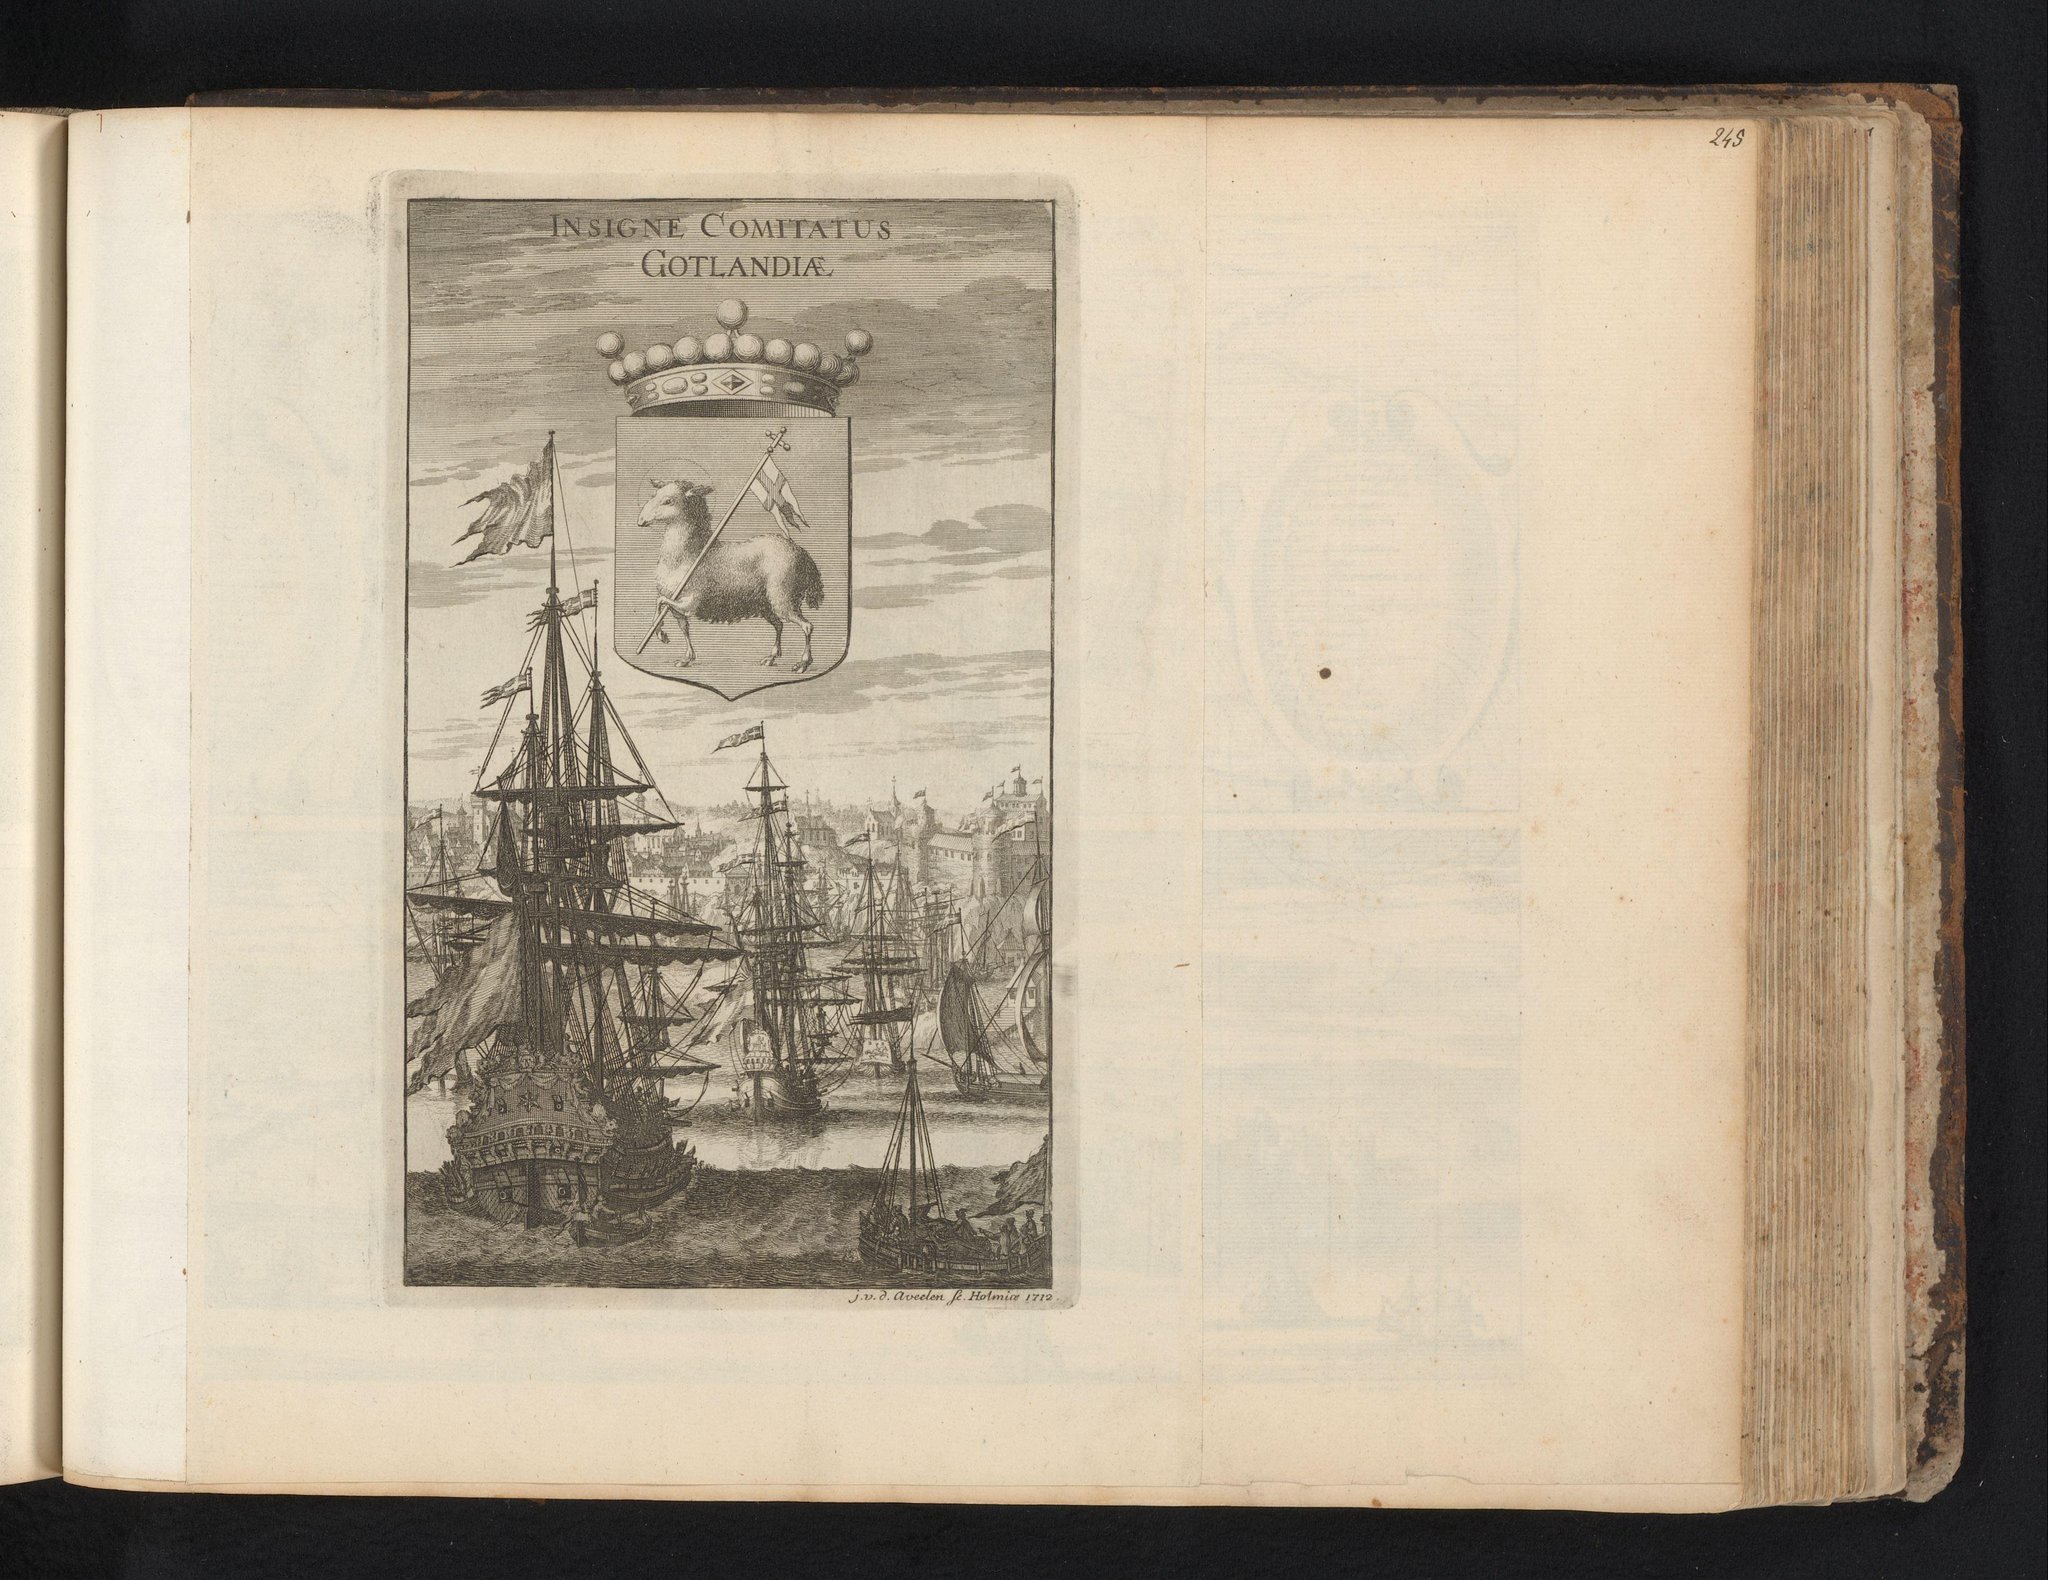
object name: print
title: Landschap met schepen en het wapen van Gotland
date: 1712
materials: paper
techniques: etching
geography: stockholm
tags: coat of arms (as symbol of the state, etc.), ships (in general)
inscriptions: date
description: Kungliga Biblioteket, 'Suecia': http://www.kb.se/samlingarna/Kartor-bilder/Suecia-antiqua/ (geraadpleegd november 2016).